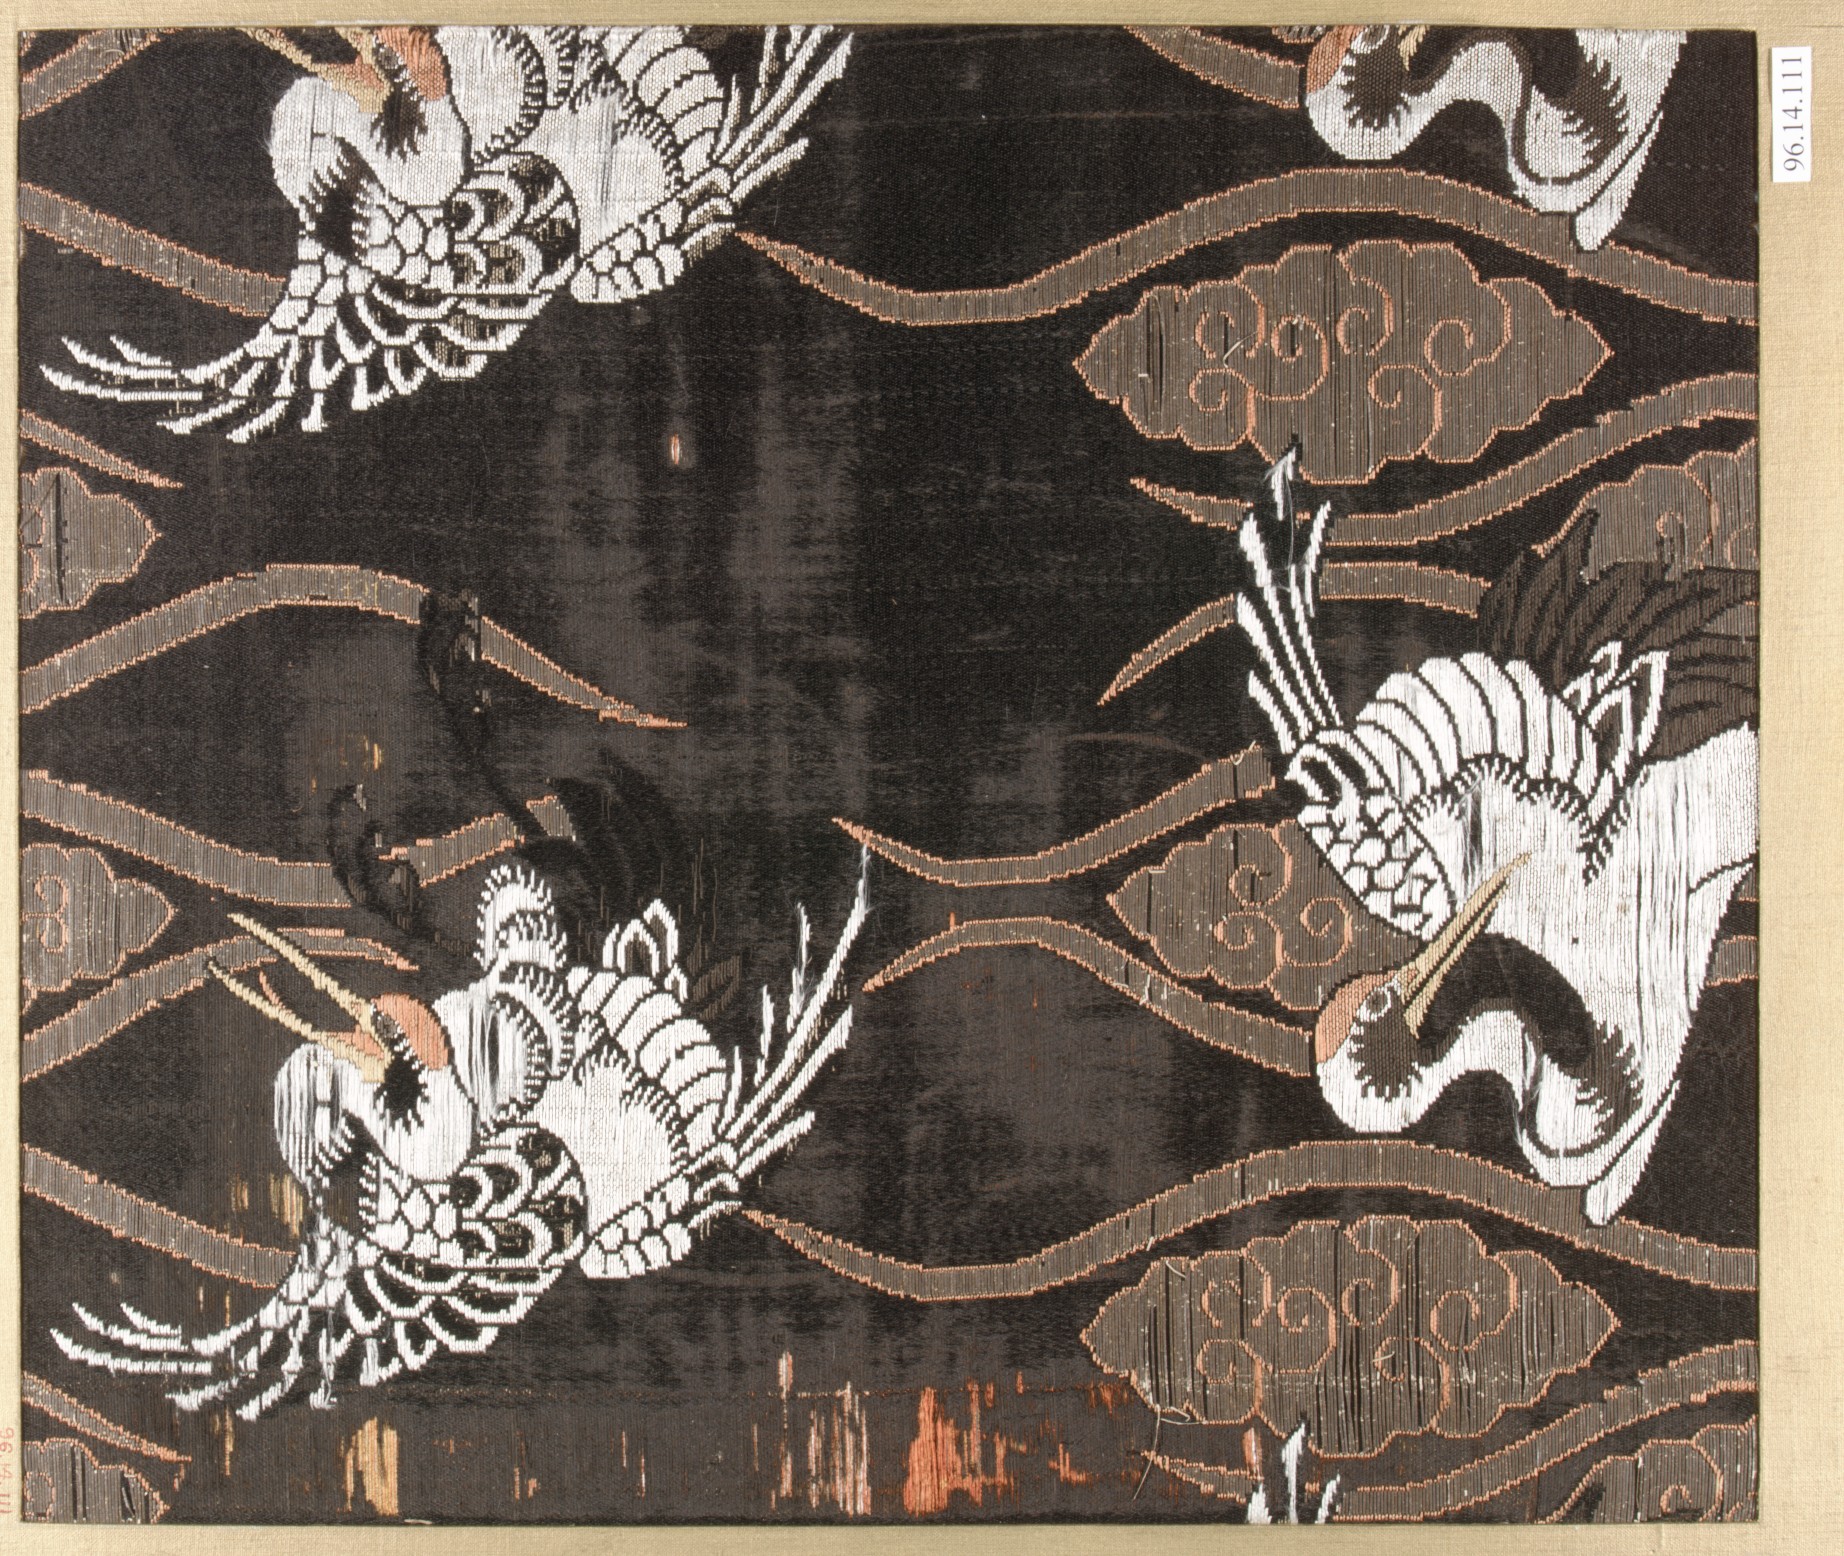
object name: piece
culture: japanese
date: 1701-1900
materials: silk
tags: cranes